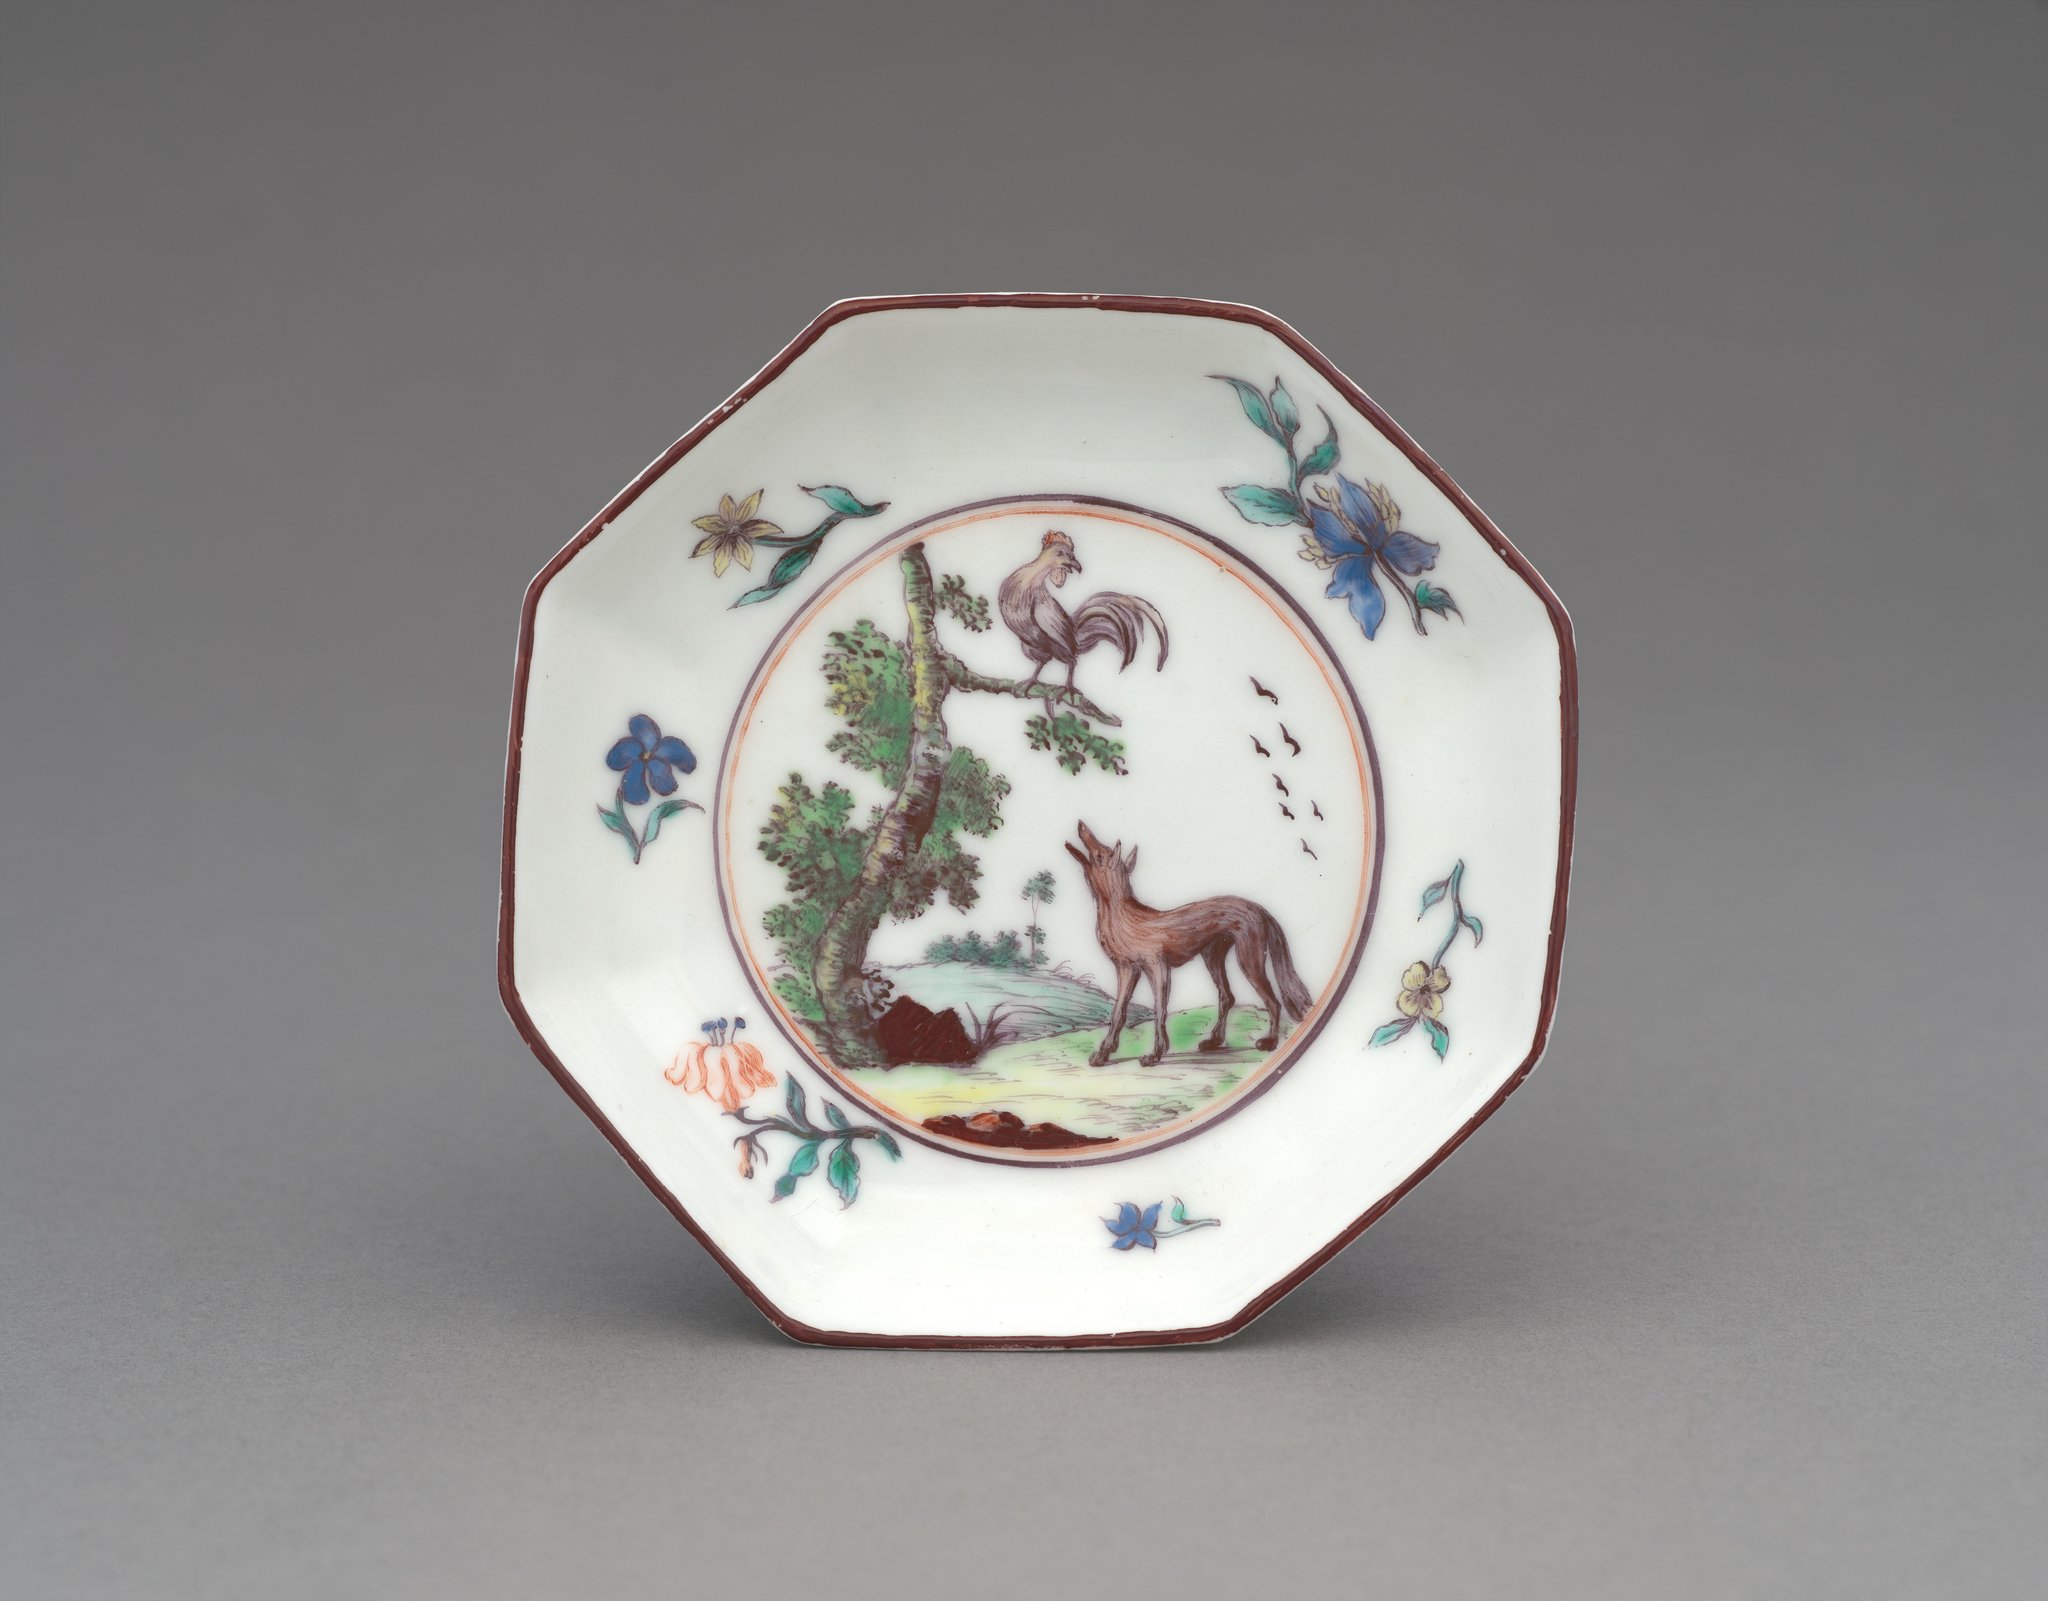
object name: saucer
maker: chelsea porcelain manufactory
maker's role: factory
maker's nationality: british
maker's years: 1744-1784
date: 1752-1755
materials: soft paste porcelain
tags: roosters,foxes